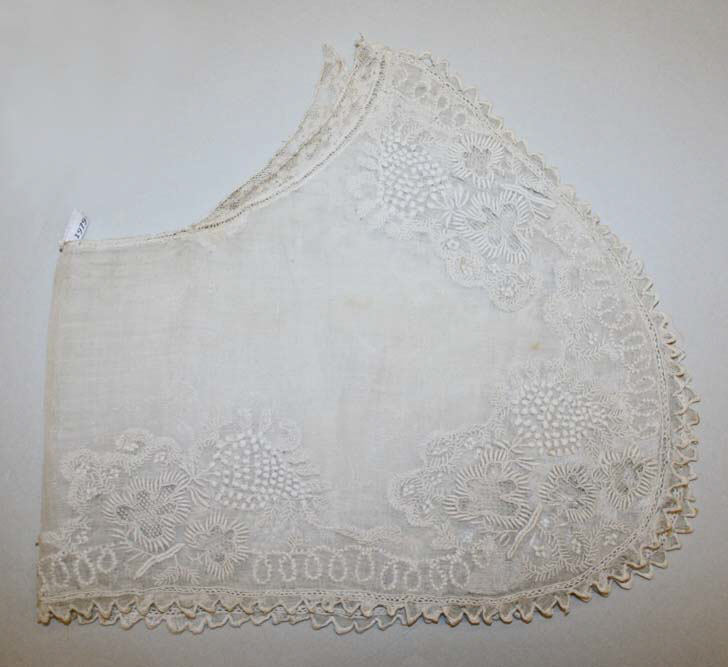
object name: pelerine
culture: british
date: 1830-1839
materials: cotton